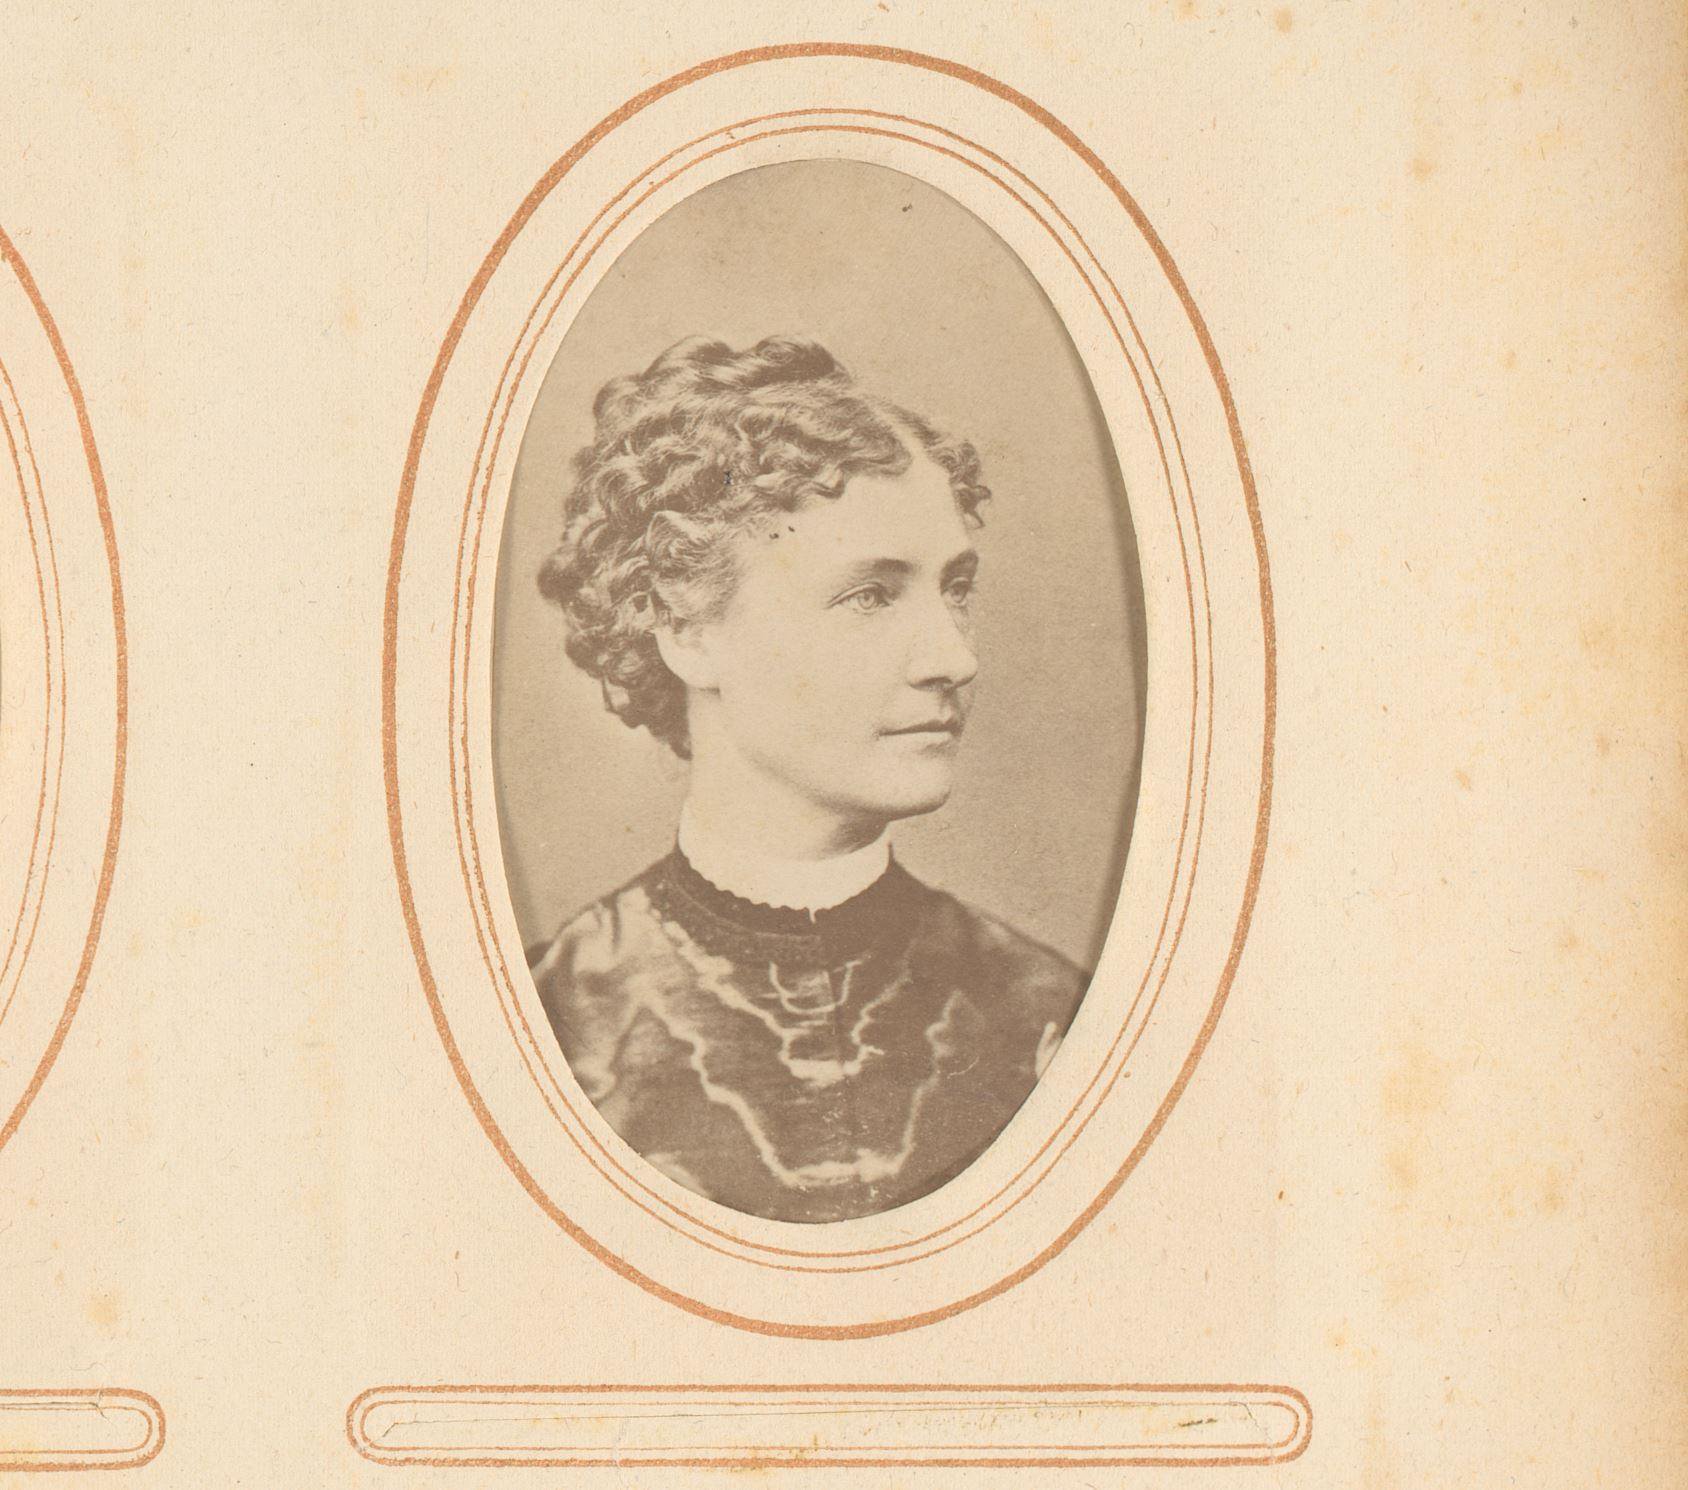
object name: carte de visite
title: Portret van Elise Hwasser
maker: Anonymous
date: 1855-1890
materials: cardboard, photographic support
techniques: albumen print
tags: adult woman, historical persons, portrait of actor, actress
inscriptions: annotation: ‘Elise Hwasser/ [...] Jacobsson/ 1831-1894’